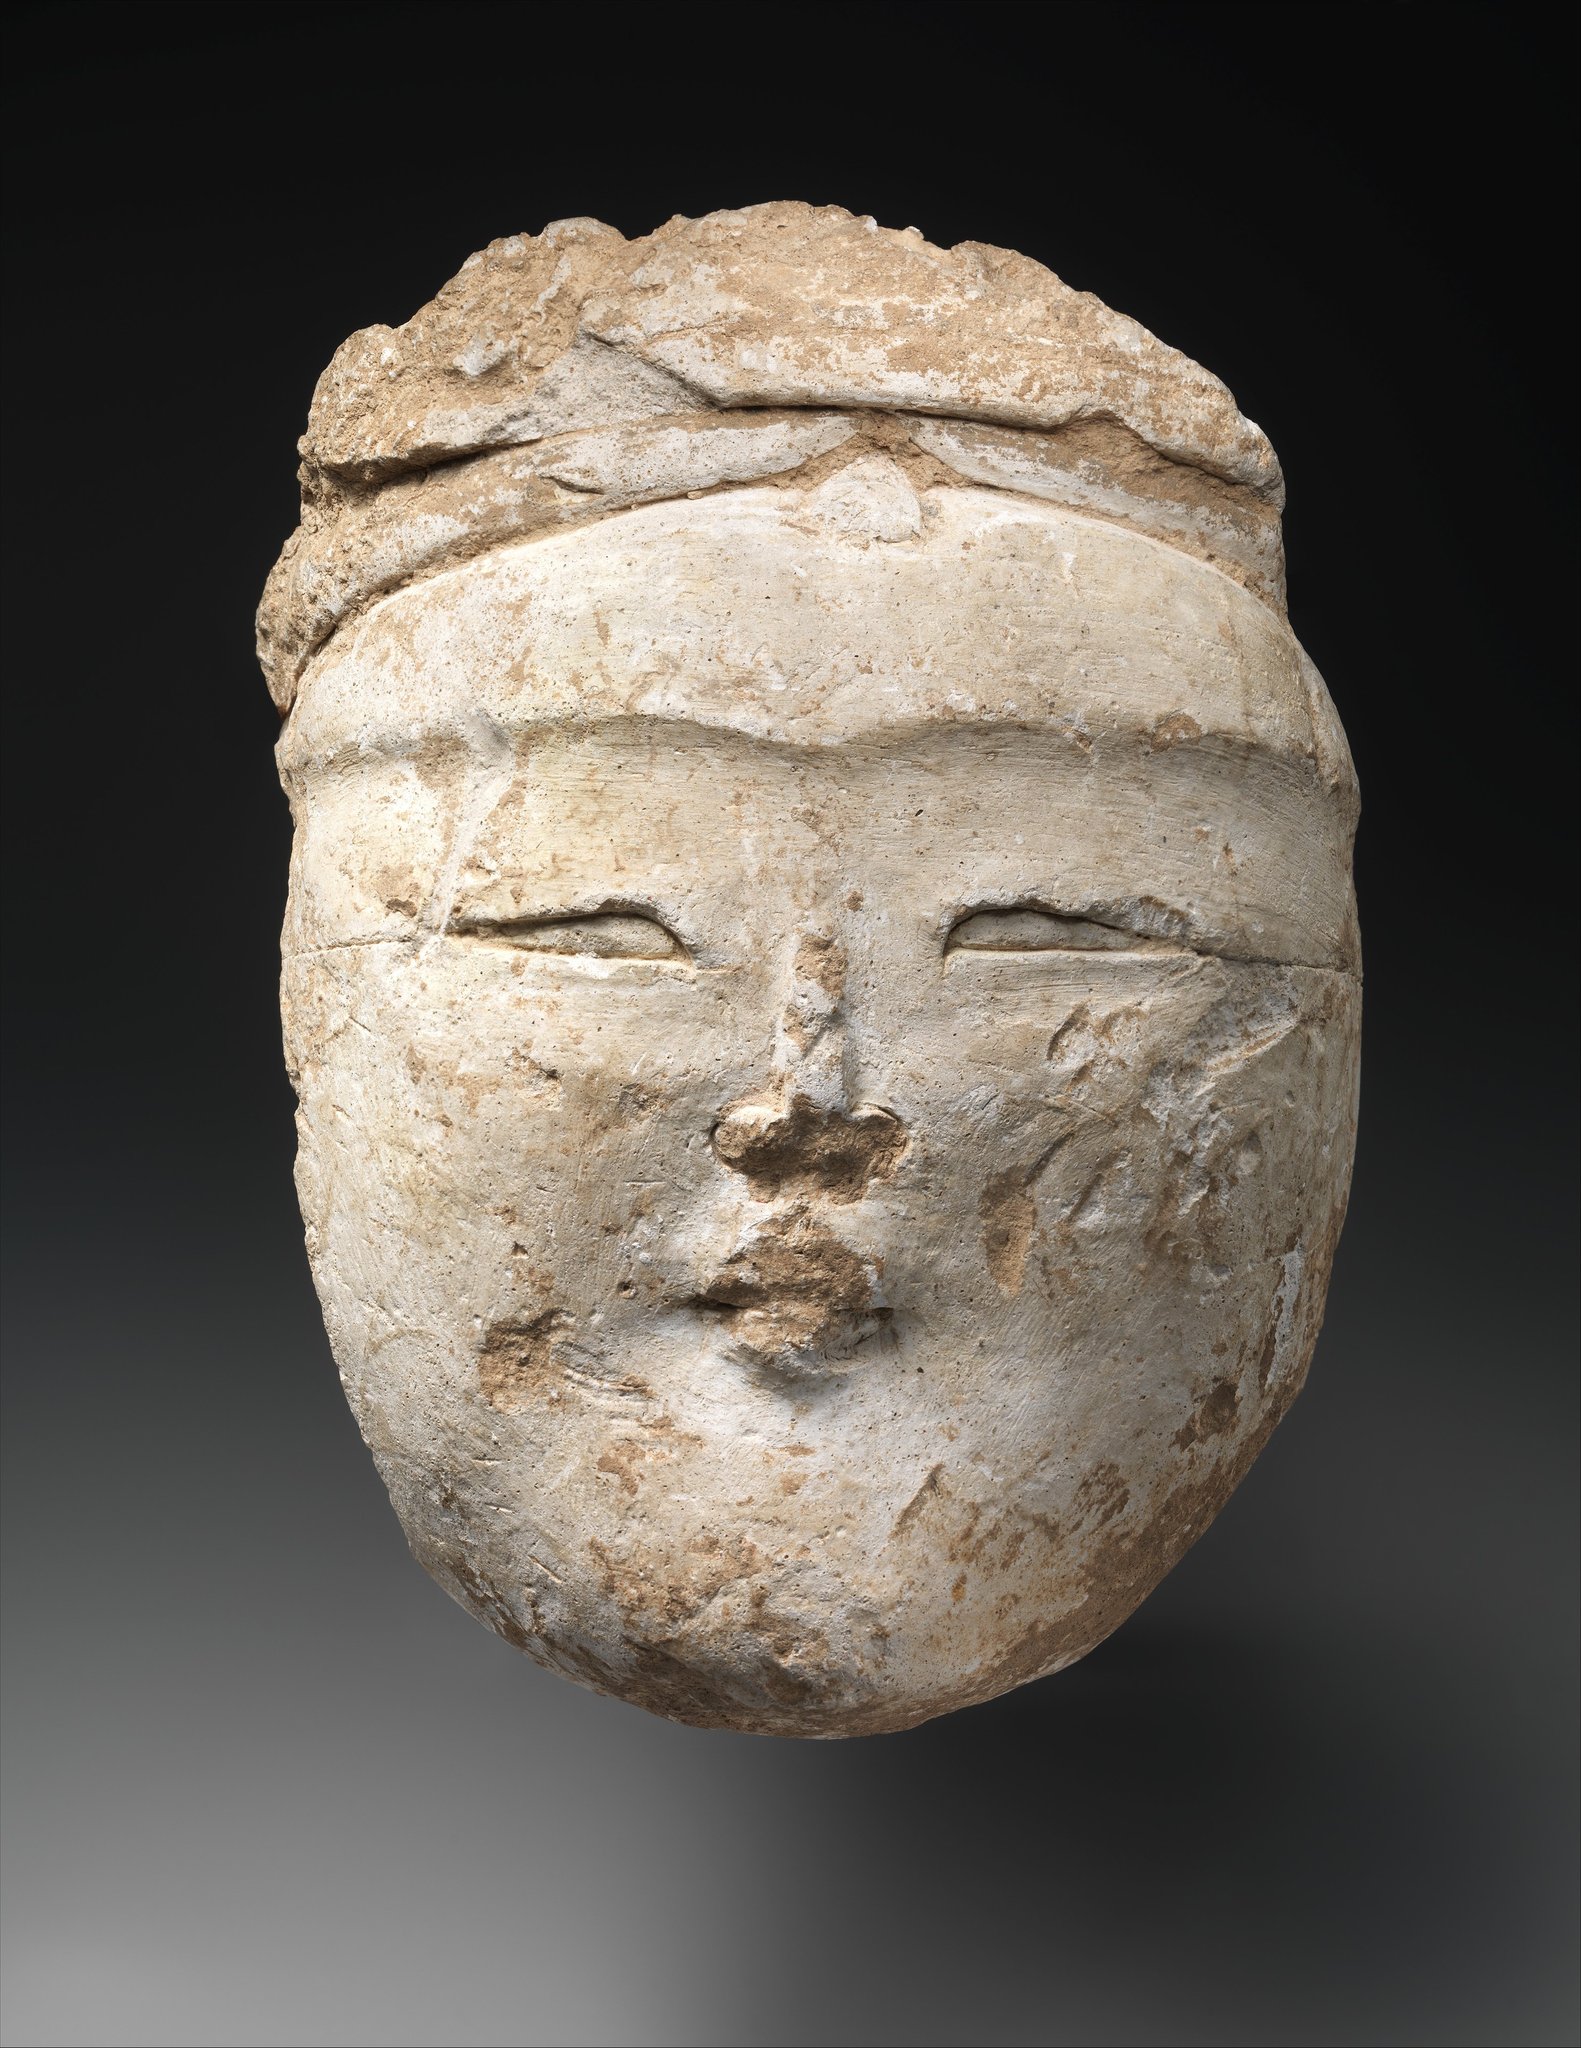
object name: head of a figure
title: Head of a Central Asian Figure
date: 1101-1300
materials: gypsum, plaster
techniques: carving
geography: iran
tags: heads